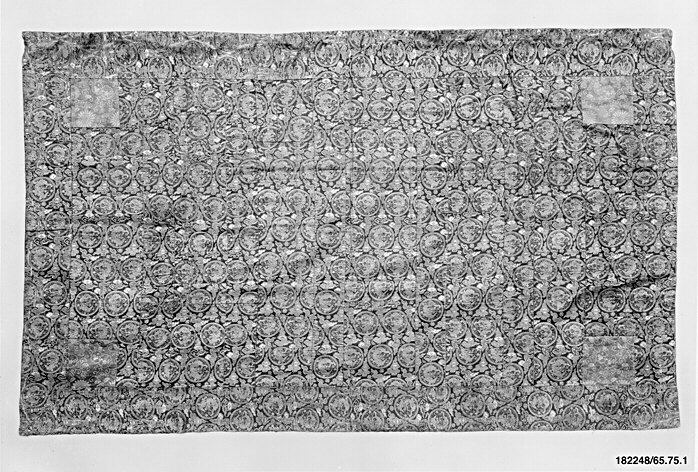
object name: robe, priest's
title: Priest's Robe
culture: japanese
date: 1701-1733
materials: metal thread, silk